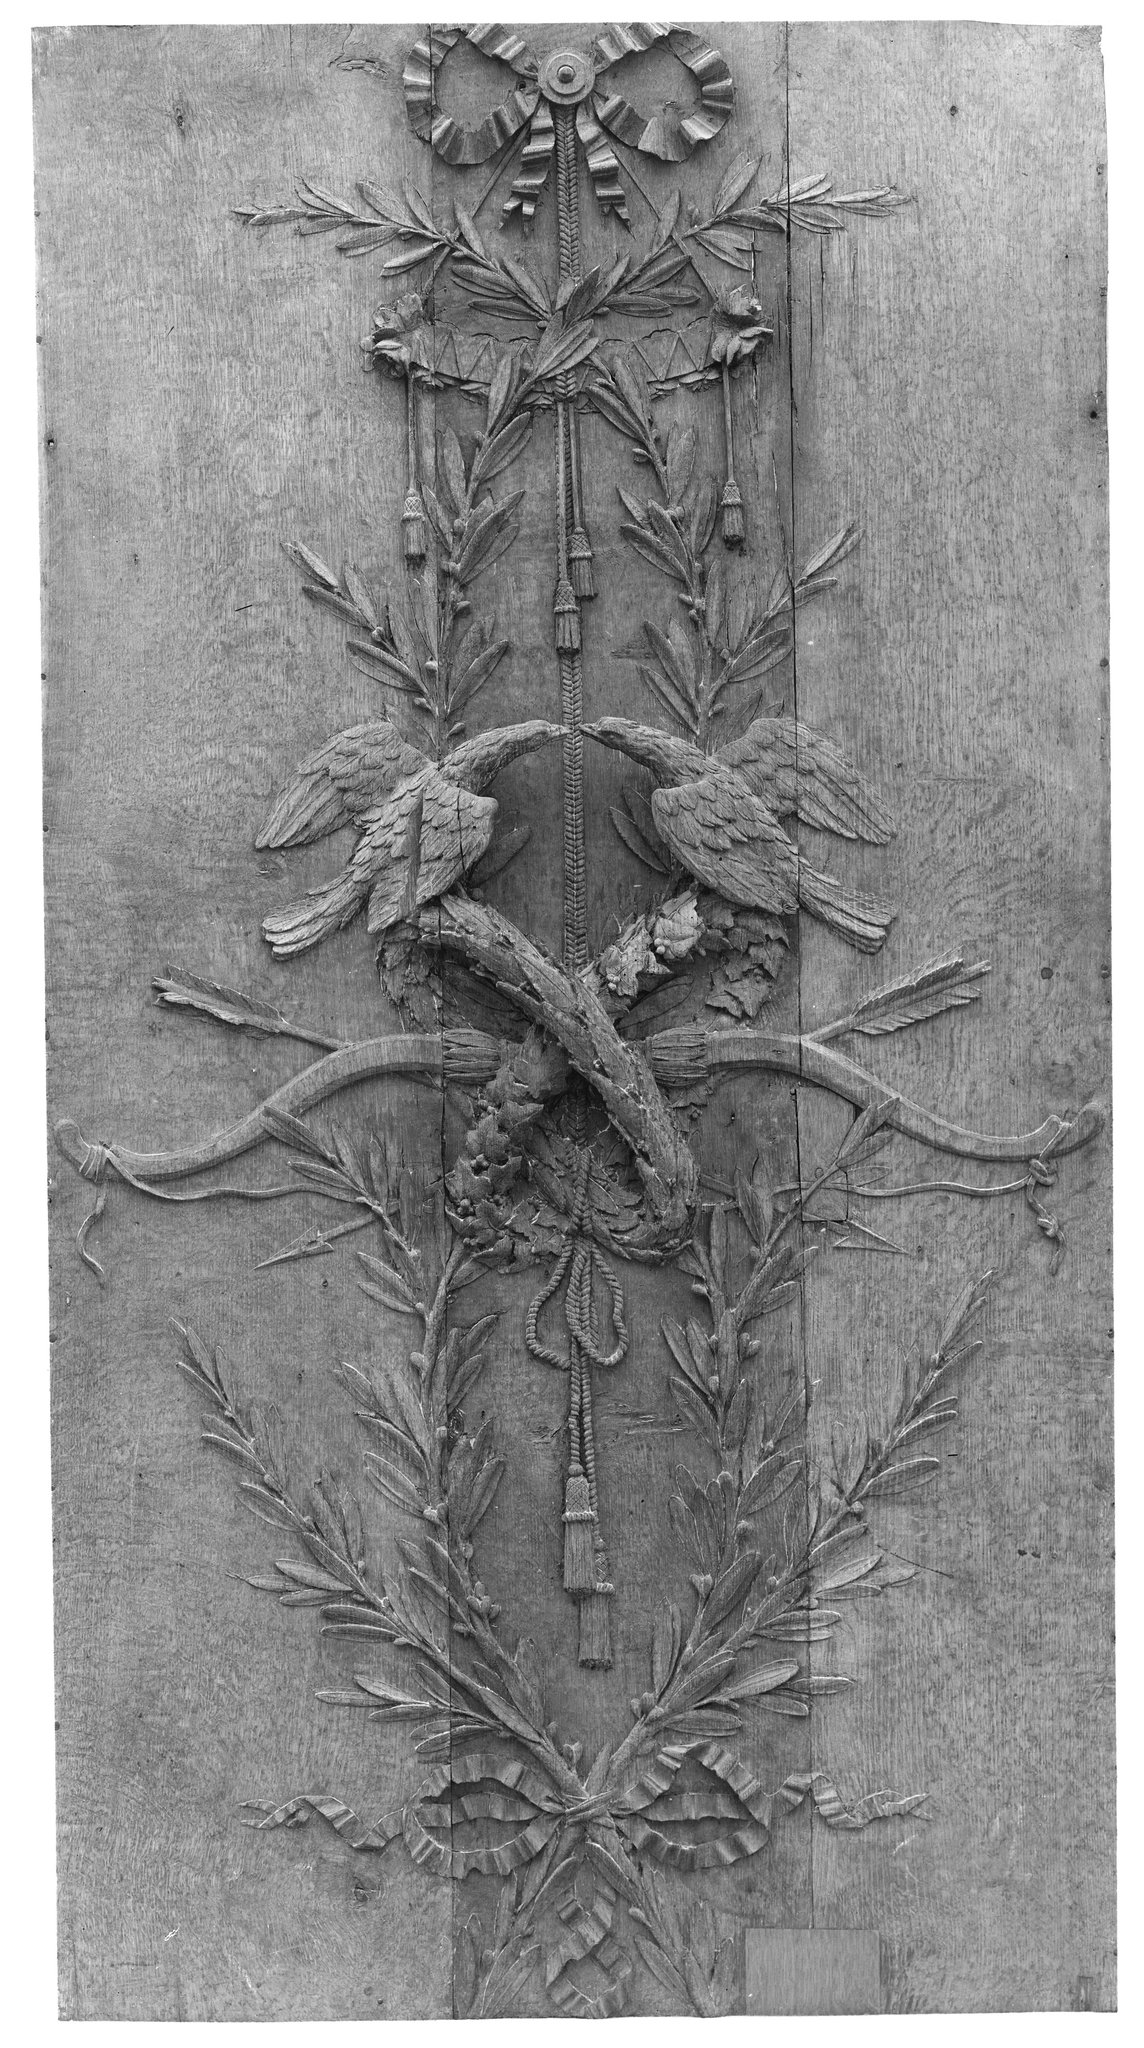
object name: panel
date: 1701-1800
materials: wood, wax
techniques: polish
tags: birds,leaves